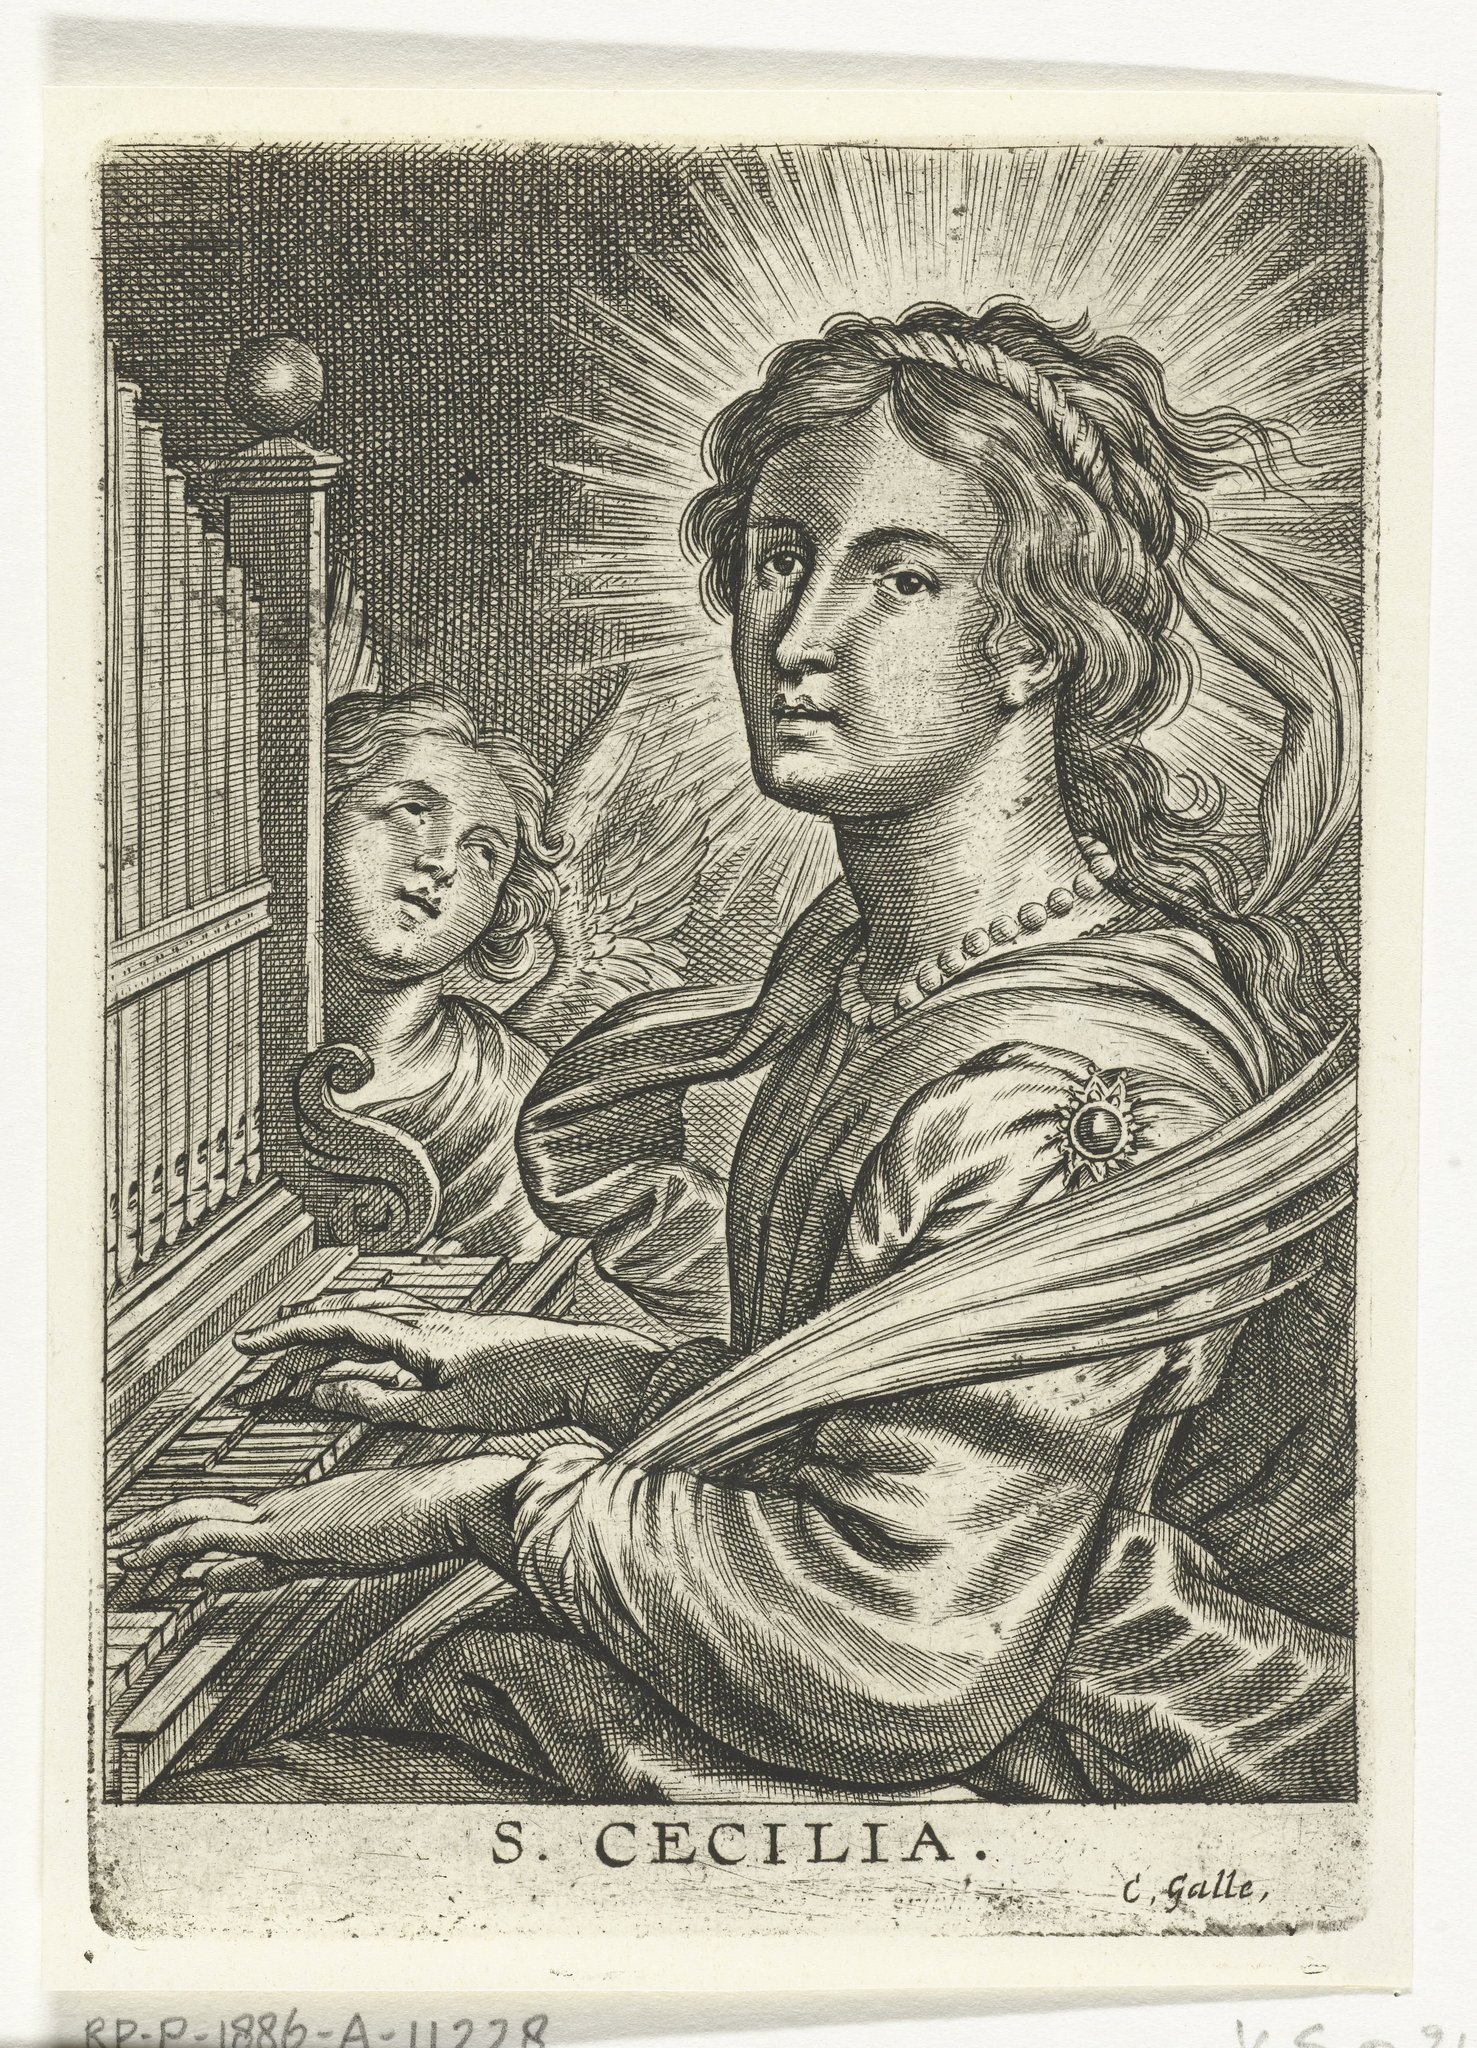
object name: print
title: S. Cecilia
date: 1596-1659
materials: paper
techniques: engraving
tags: male saints (with name)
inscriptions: collector's mark: Lugt 2228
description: Prent naar ontwerp van Peter Paul Rubens.